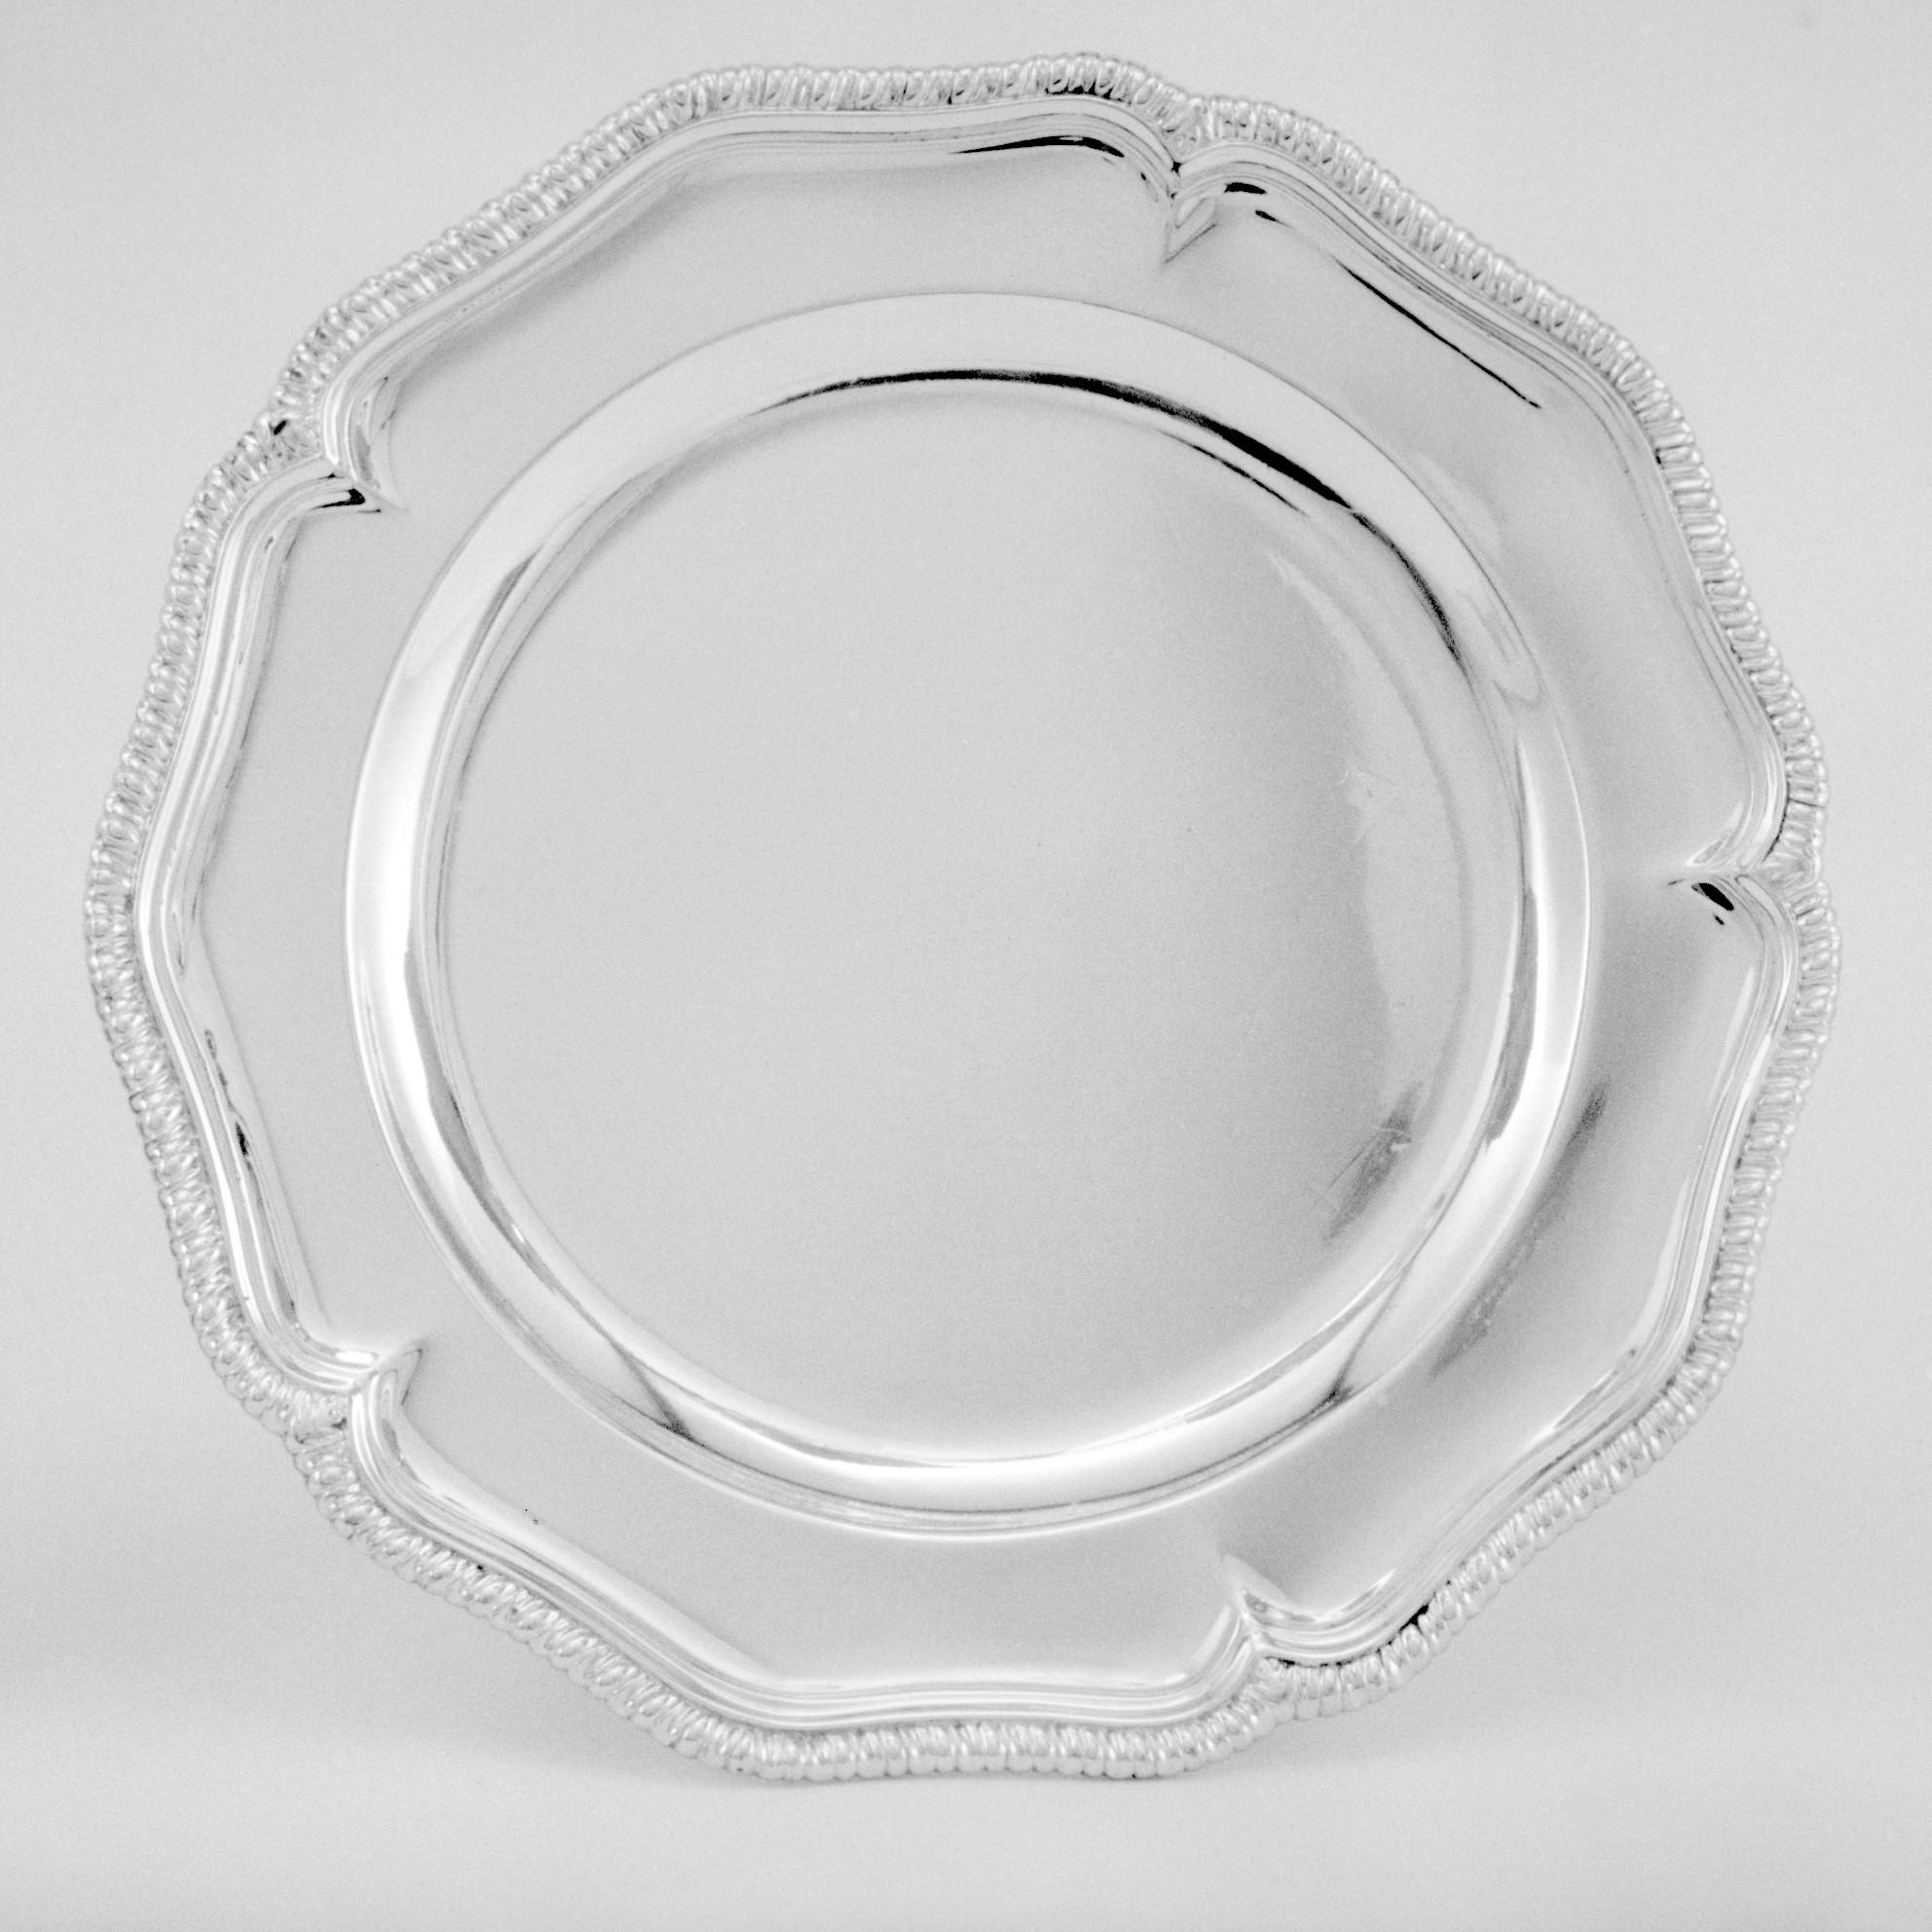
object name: dish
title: Dishes (two from a set of six)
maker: paul de lamerie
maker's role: maker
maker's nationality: british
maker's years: 1688-1751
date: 1746-1747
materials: silver